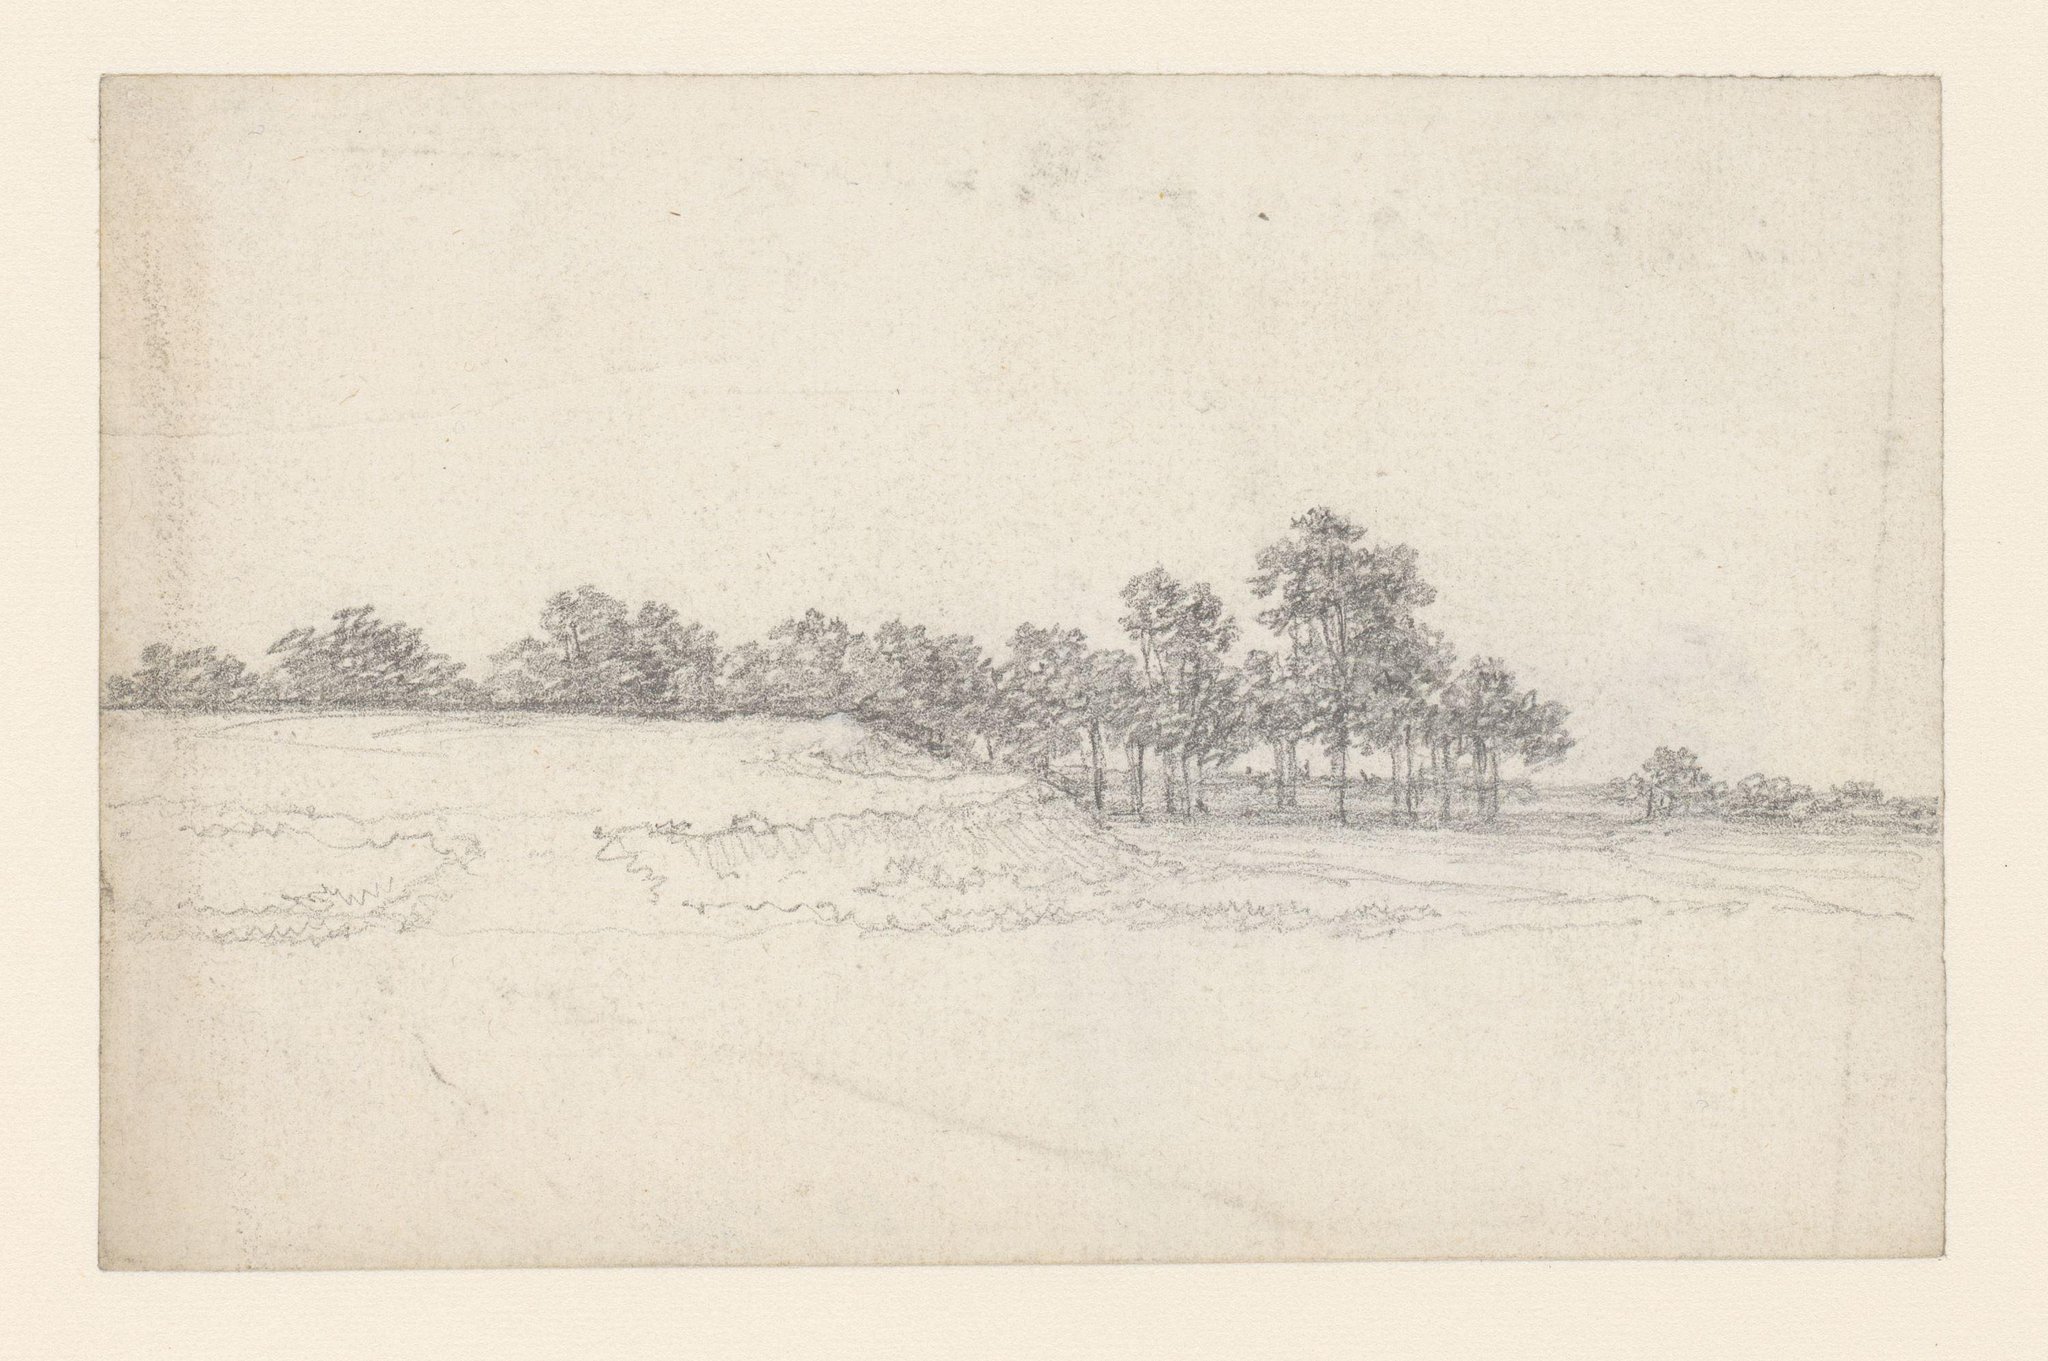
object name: drawing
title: Terreinplooi met bomen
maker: georges michel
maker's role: draughtsman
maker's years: 1763-1843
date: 1773-1843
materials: paper, pencil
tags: landscapes in the temperate zone, groups of trees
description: Een van 120 tekeningen, afkomstig uit een 19e eeuws album met tekeningen van Georges Michel.